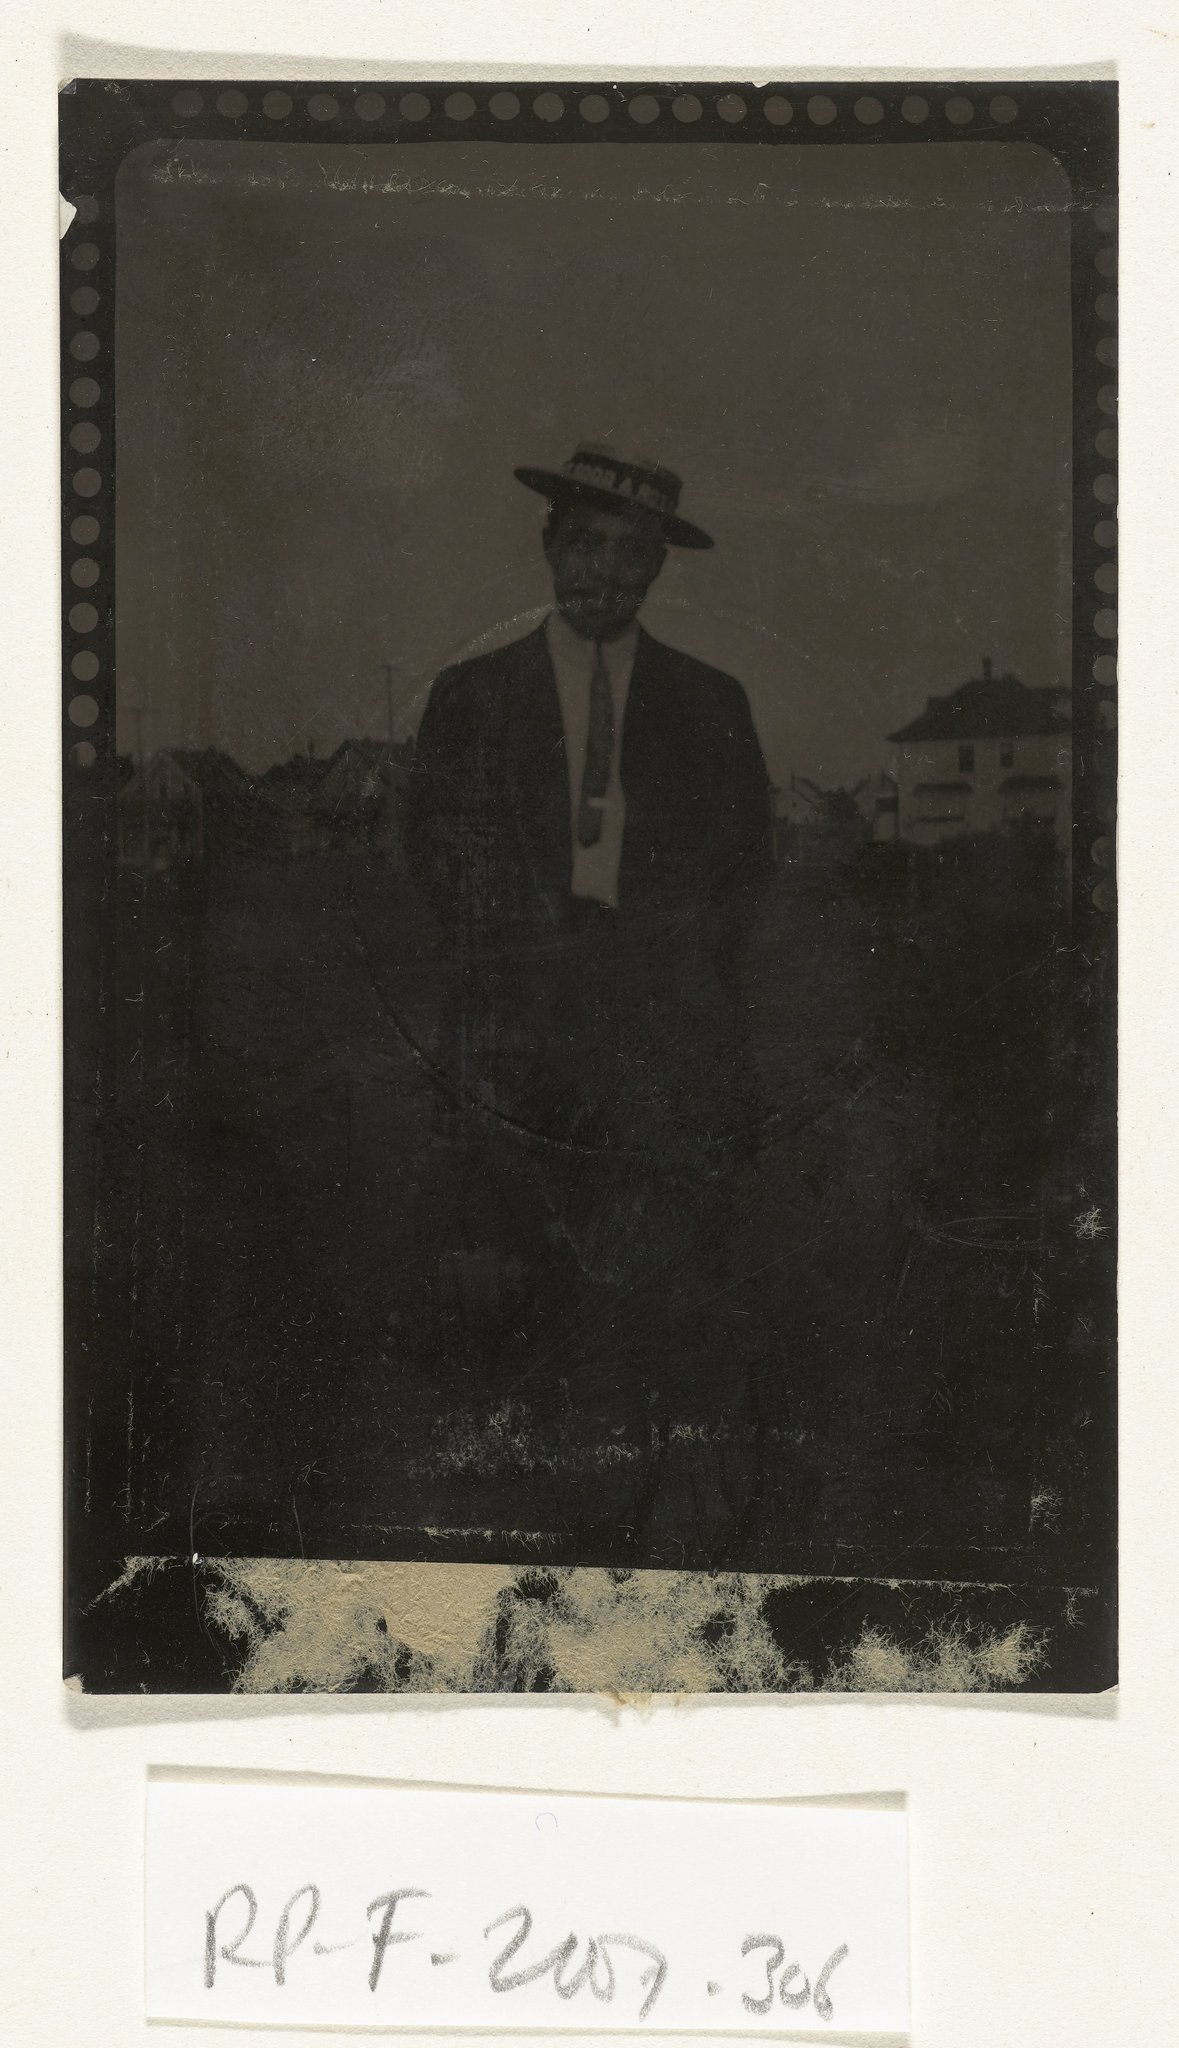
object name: photograph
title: Portret van een man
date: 1911-1925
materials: cardboard, metal, paper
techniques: ferrotyping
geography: united states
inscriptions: inscription: ‘POST CARD / CORRSPONDANCE / ADDRESS / MANDEL'S / POSITIVE / PROCESS / NO NEGATIVES / COPYRIGHT 1911 BY THE CHICAGO FERROTYPE CO.’